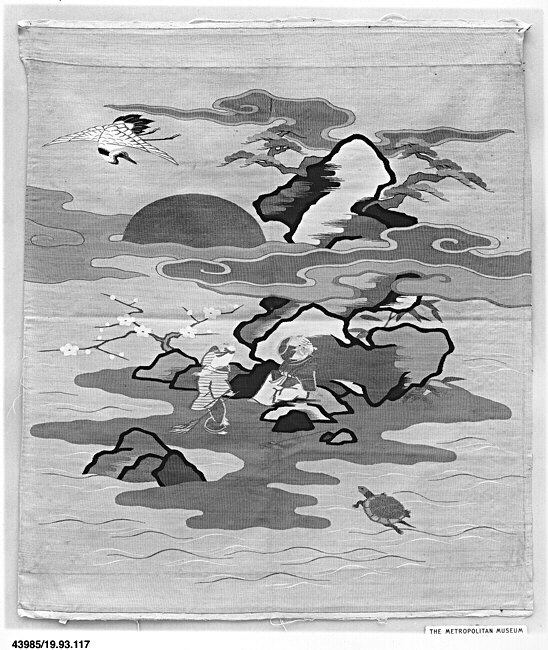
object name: gift cloth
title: Gift Cloth (Fukusa)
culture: japanese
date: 1716-1736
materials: metal thread, silk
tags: cranes,turtles